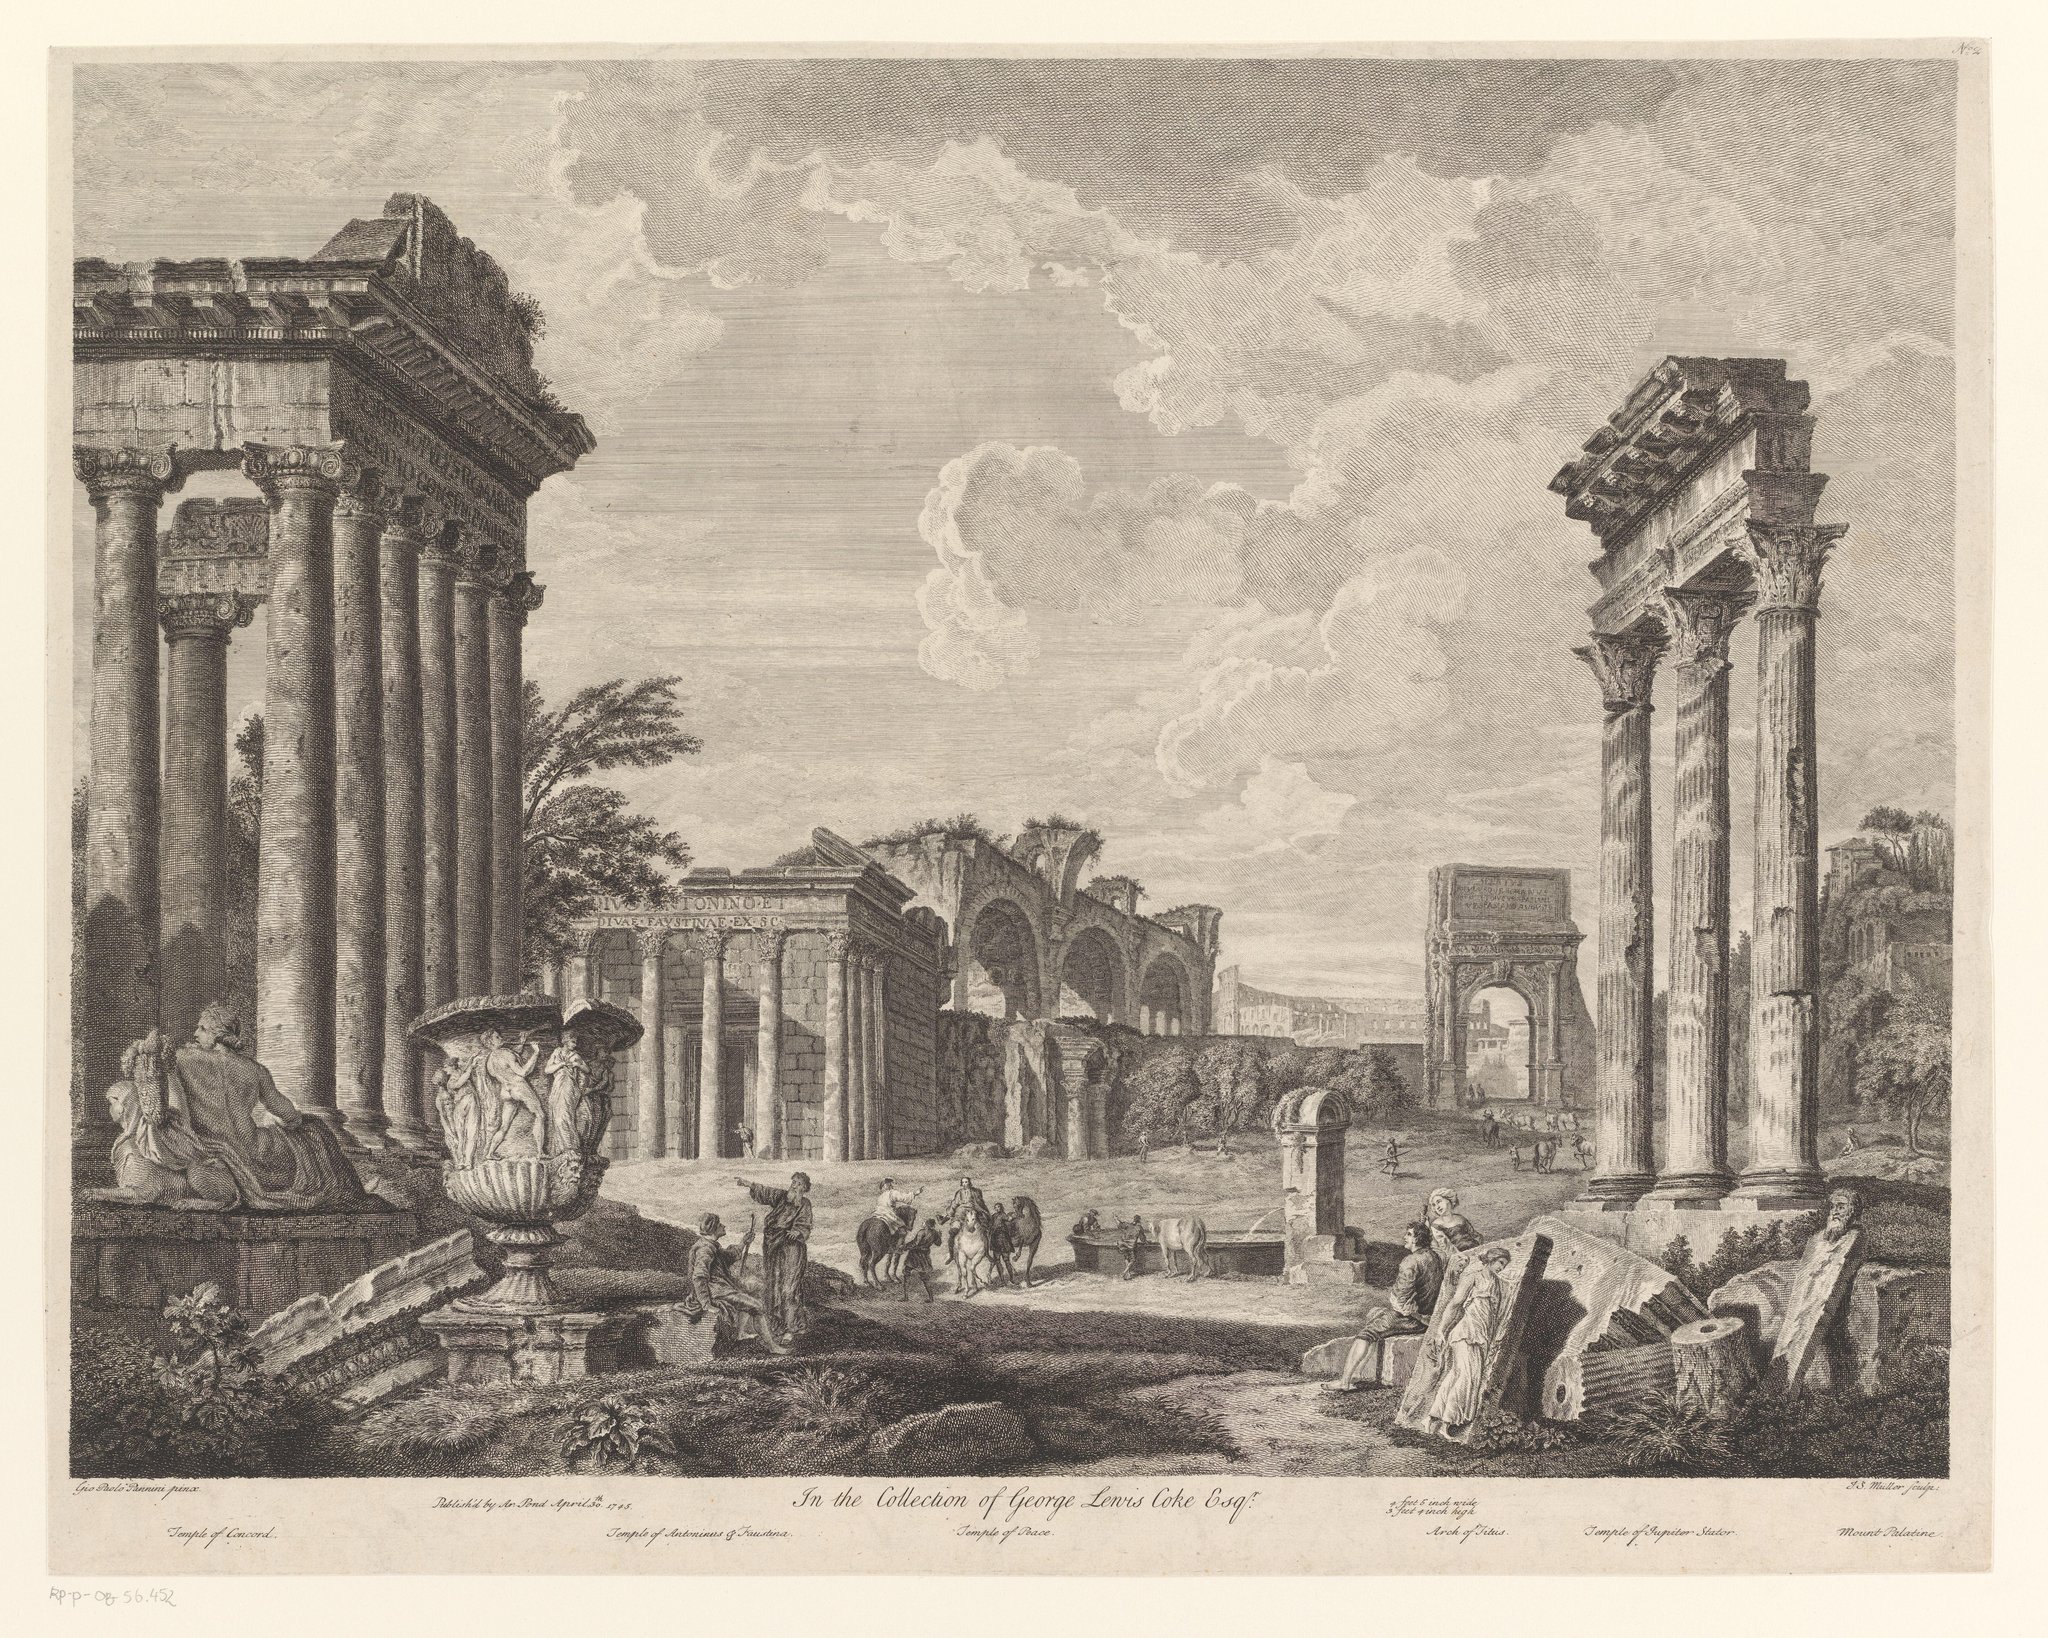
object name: print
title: Ruïnelandschap met de Tempel van Antonius en Faustina, de Boog van Titus en de Tempel van Jupiter Optimus Maximus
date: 1745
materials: paper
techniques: etching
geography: london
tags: landscape with ruins (+ city(-scape) with figures, staffage)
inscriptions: collector's mark: Lugt 2228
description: Tekst in het Engels in de ondermarge. Op de achtergrond het Colosseum, de Basilica van Maxentius en rechts de Palatijn.